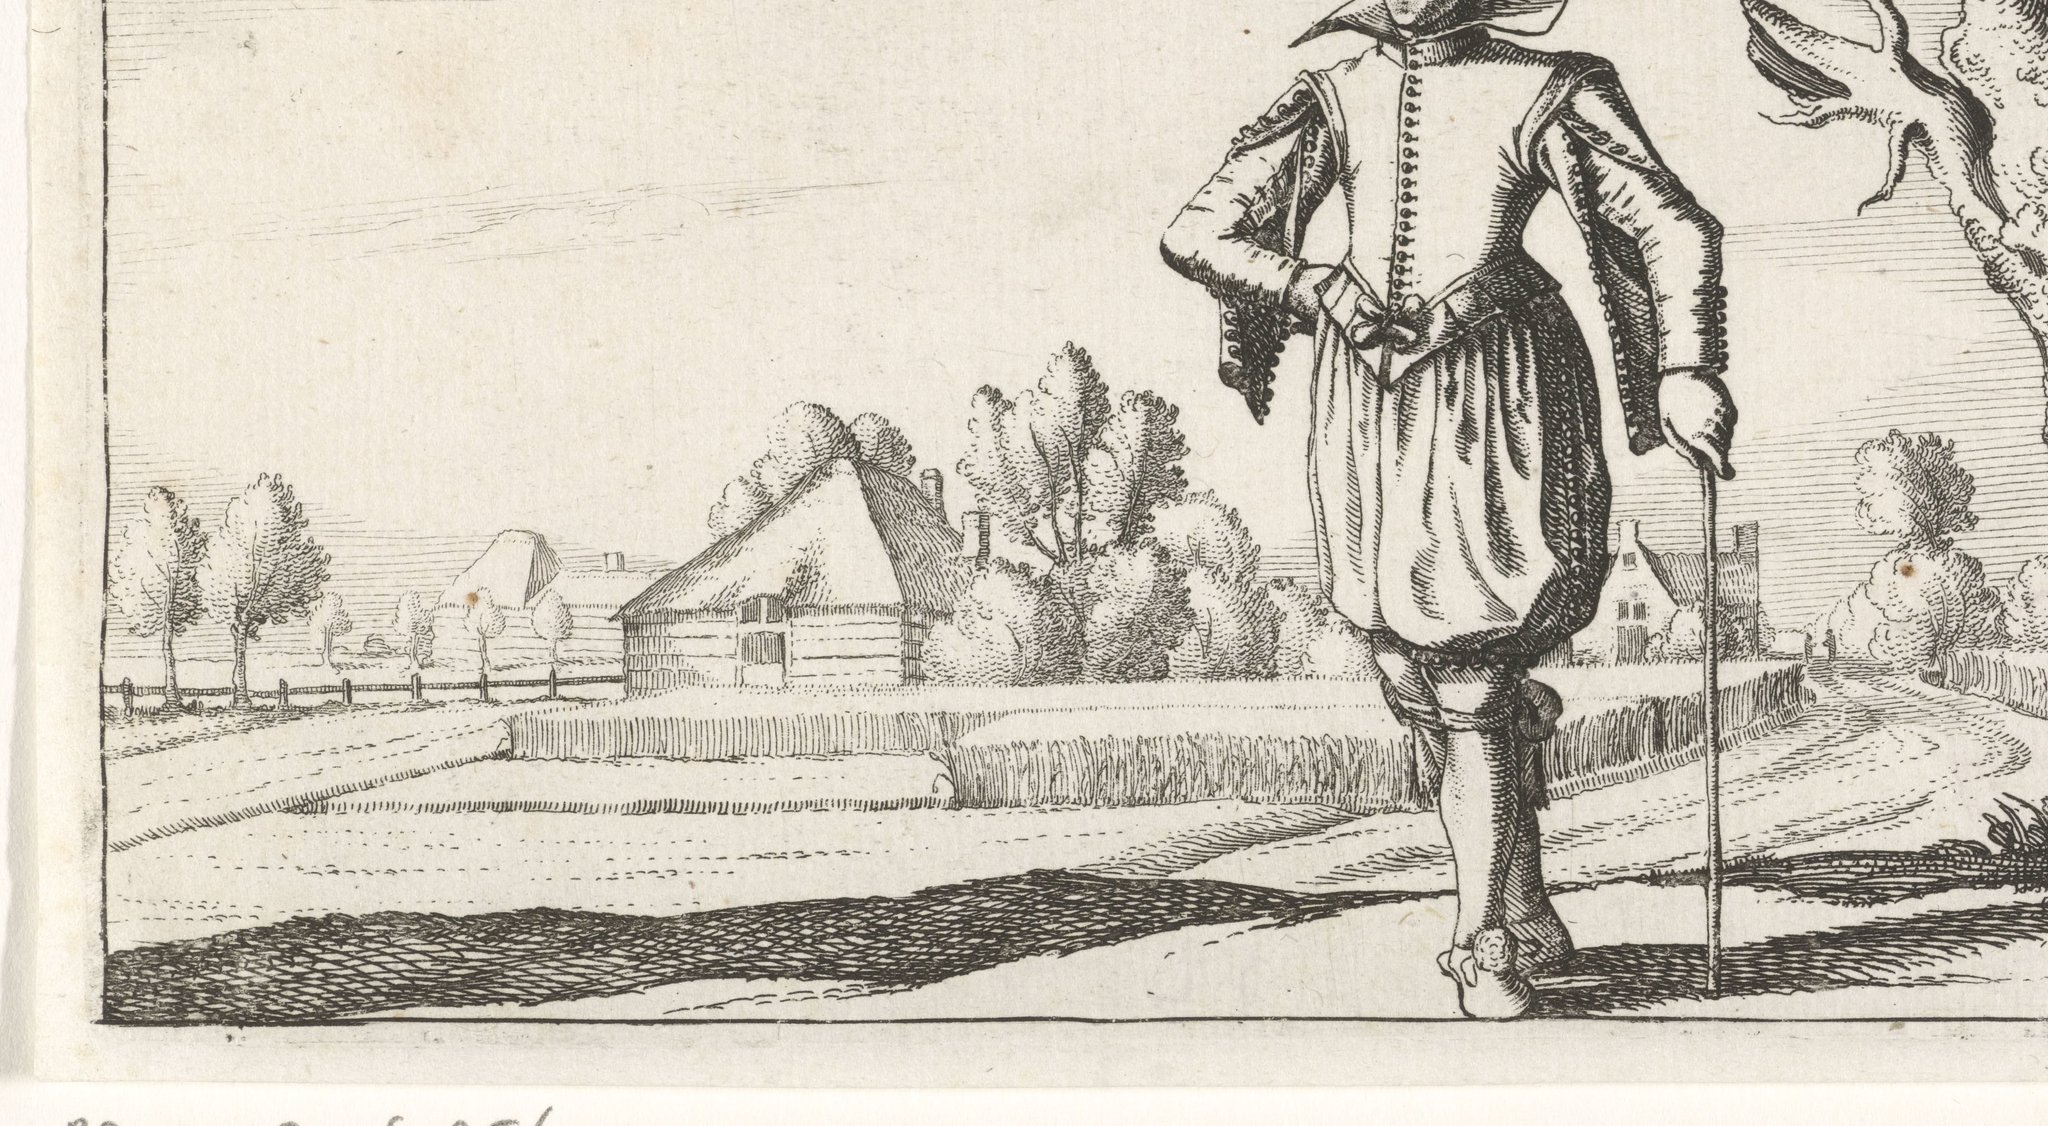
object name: costume print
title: Man met wandelstok in een landschap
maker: dirk eversen lons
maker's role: print maker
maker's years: 1599-1686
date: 1622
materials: paper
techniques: engraving, etching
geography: amsterdam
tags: walking-stick, staff, clothes, costume (+ men's clothes), farm or solitary house in landscape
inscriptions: collector's mark: Lugt 240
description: Op de voorgrond een staande man, van voren gezien, stok in de linkerhand. Hij is gekleed volgens de burgerlijke mode van 1622. Op de achtergrond een boerderij. No. 3 uit serie van 8 prentjes met kostuums van verschillende rangen en standen.